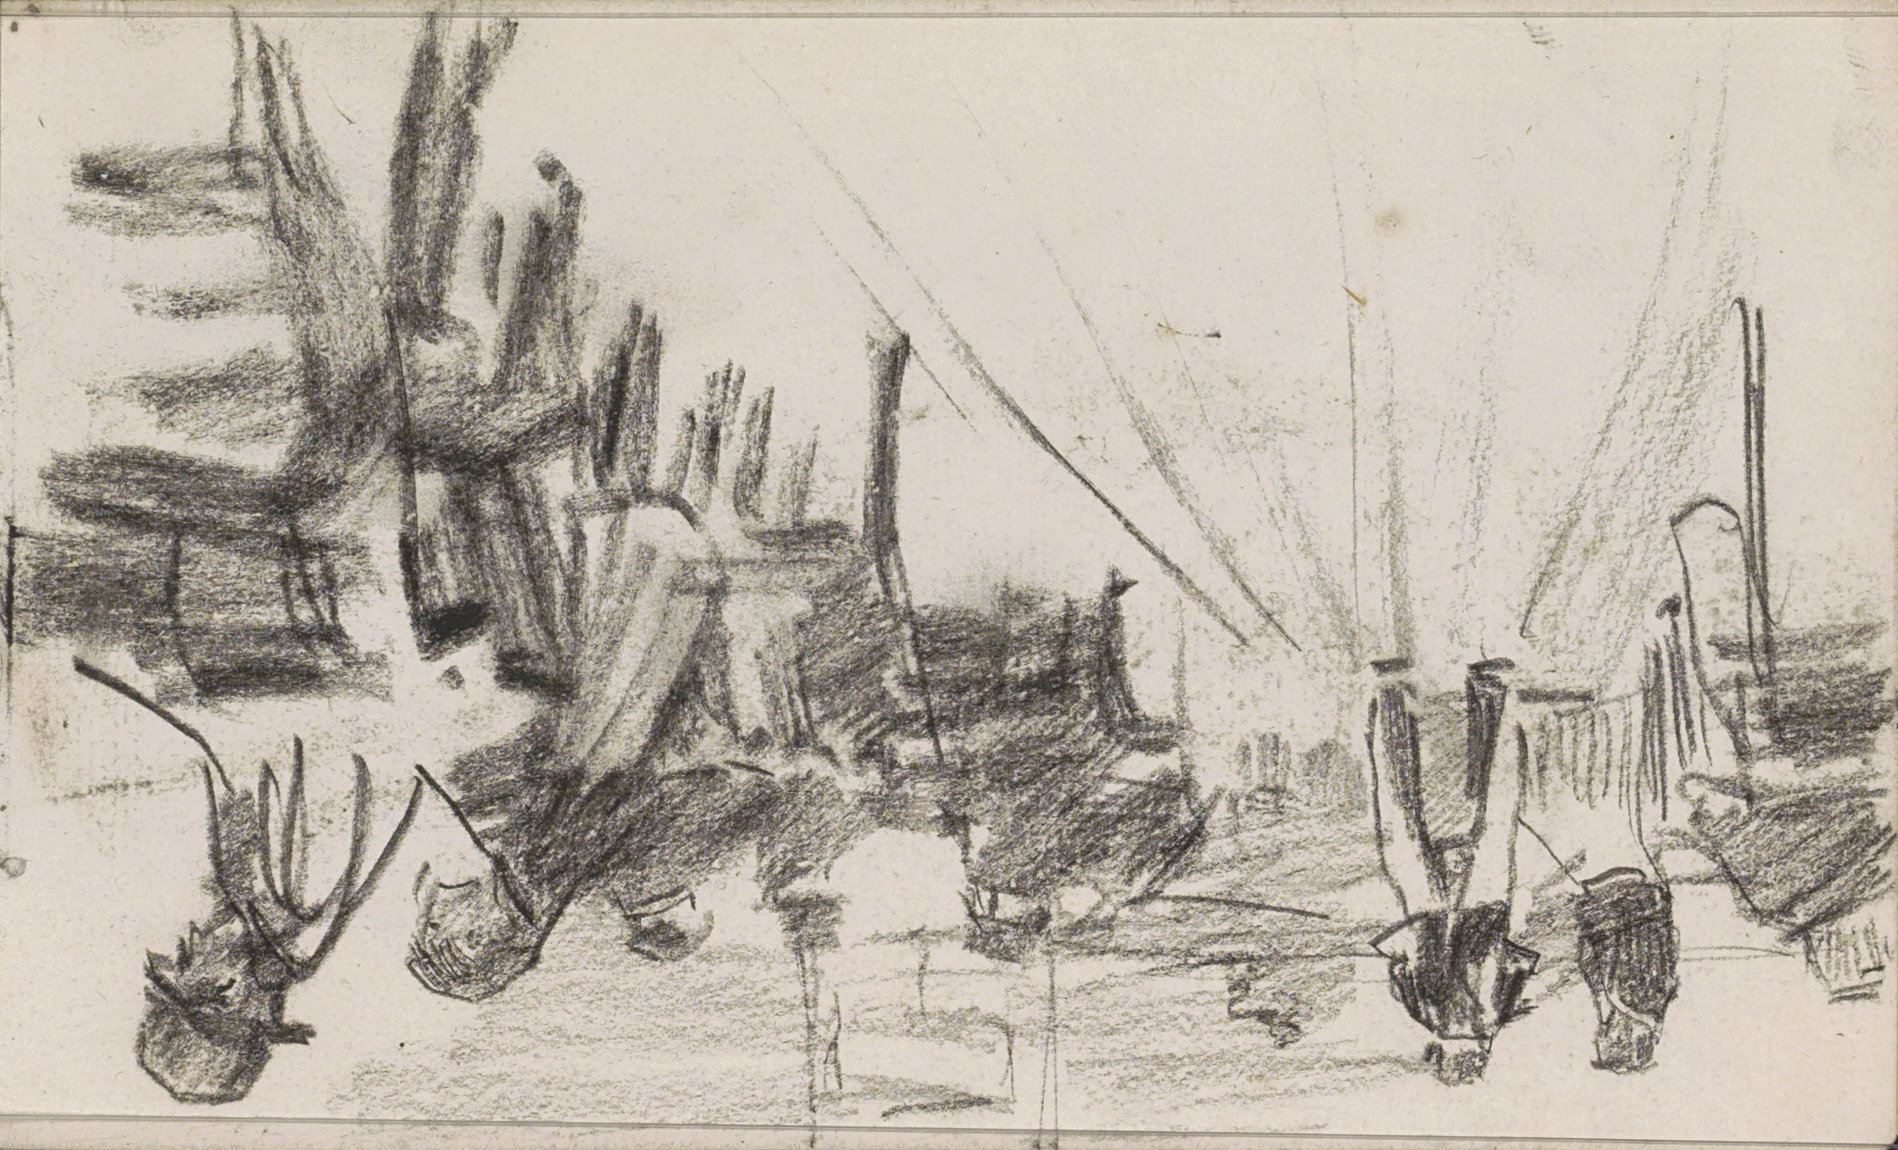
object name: sketchbook leaf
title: Mannen in een etablissement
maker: isaac israels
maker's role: draughtsman, painter, print maker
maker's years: 1865-1934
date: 1875-1934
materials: chalk, paper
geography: the hague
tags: adult man (+ sitting), inn, coffee-house, public house, etc.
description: Op de achtergrond twee obers bij een bar. Pagina 45 uit schetsboek XLVIII met 62 pagina's.